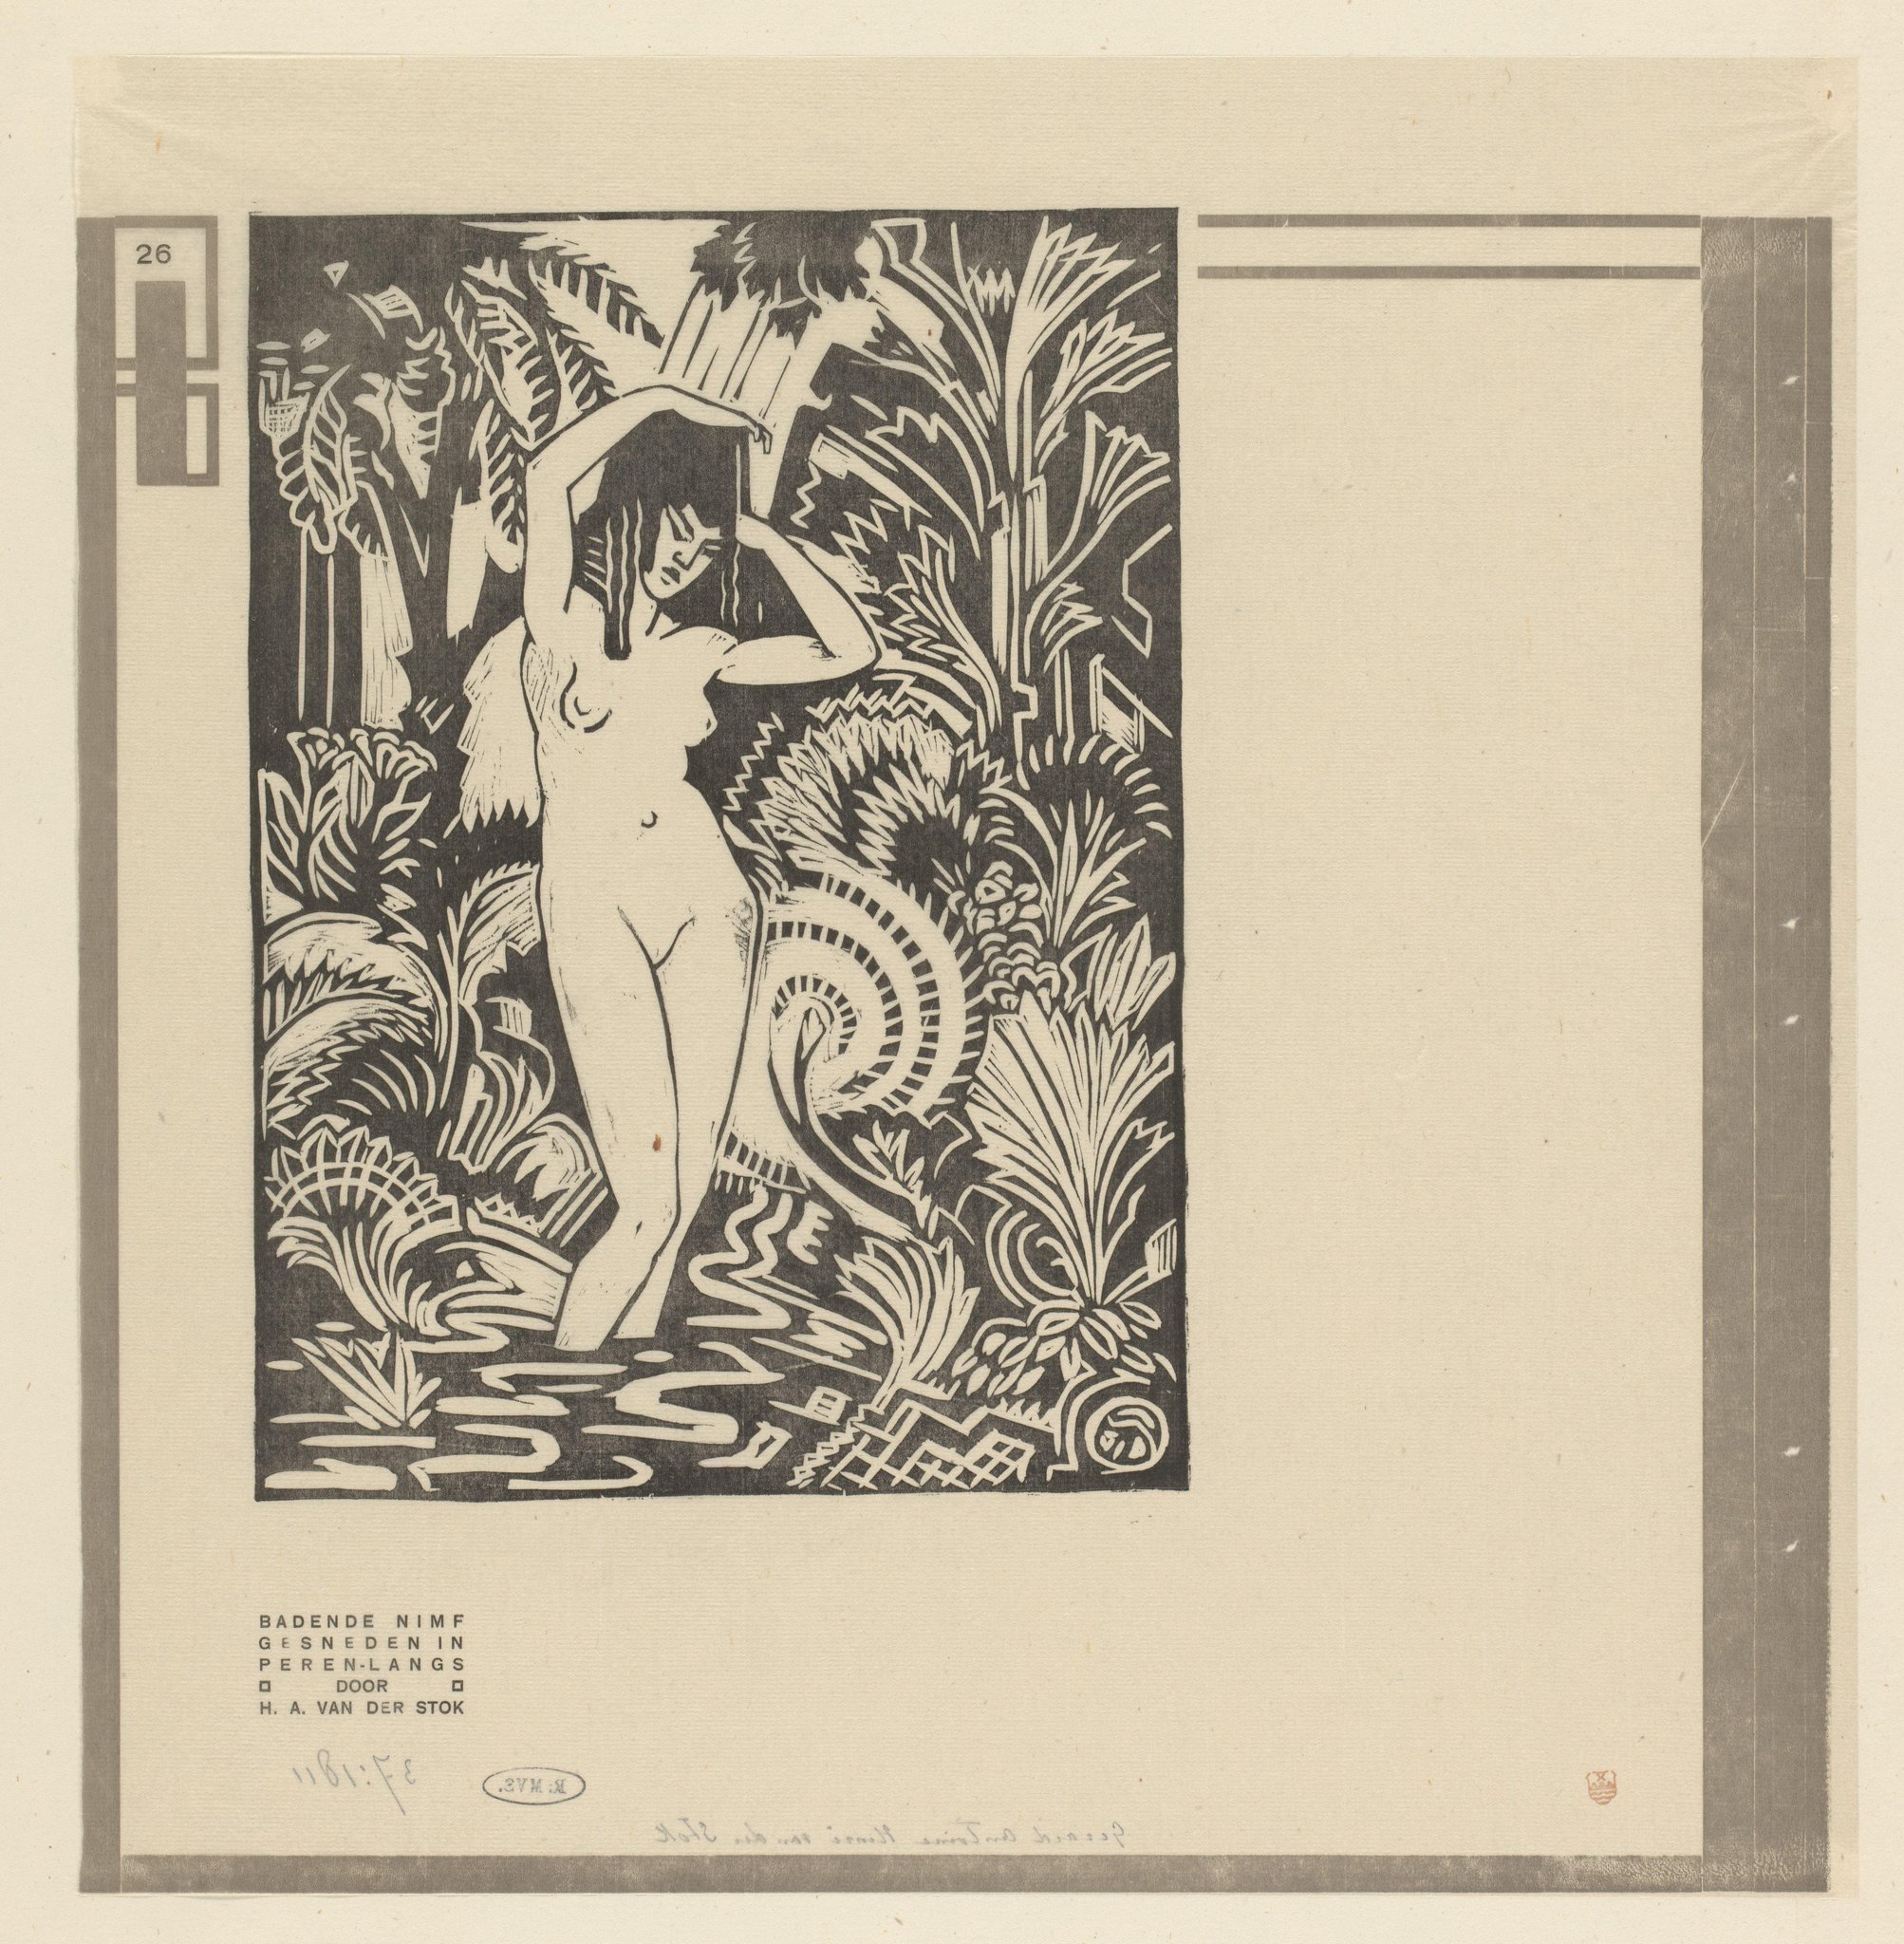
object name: print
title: Badende nimf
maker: henri van der stok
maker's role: print maker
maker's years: 1870-1946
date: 1919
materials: paper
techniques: woodcut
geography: amsterdam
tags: nymphs (in general); 'ninfe in commune' (ripa), washing and bathing - aa - in the open air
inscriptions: collector's mark: Lugt 2760, collector's mark: Lugt 2228